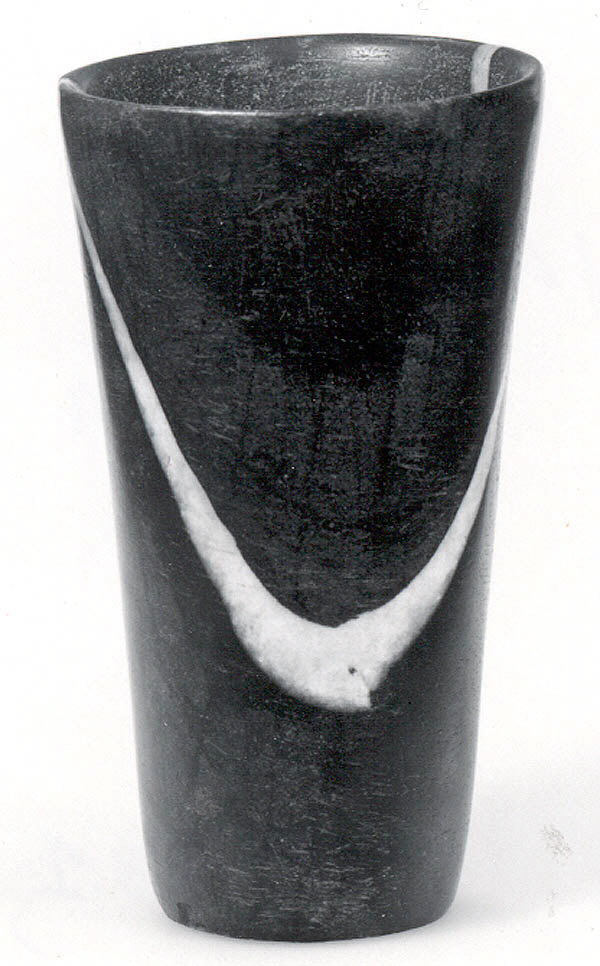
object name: beaker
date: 3100-2900 BCE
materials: marble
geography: mesopotamia